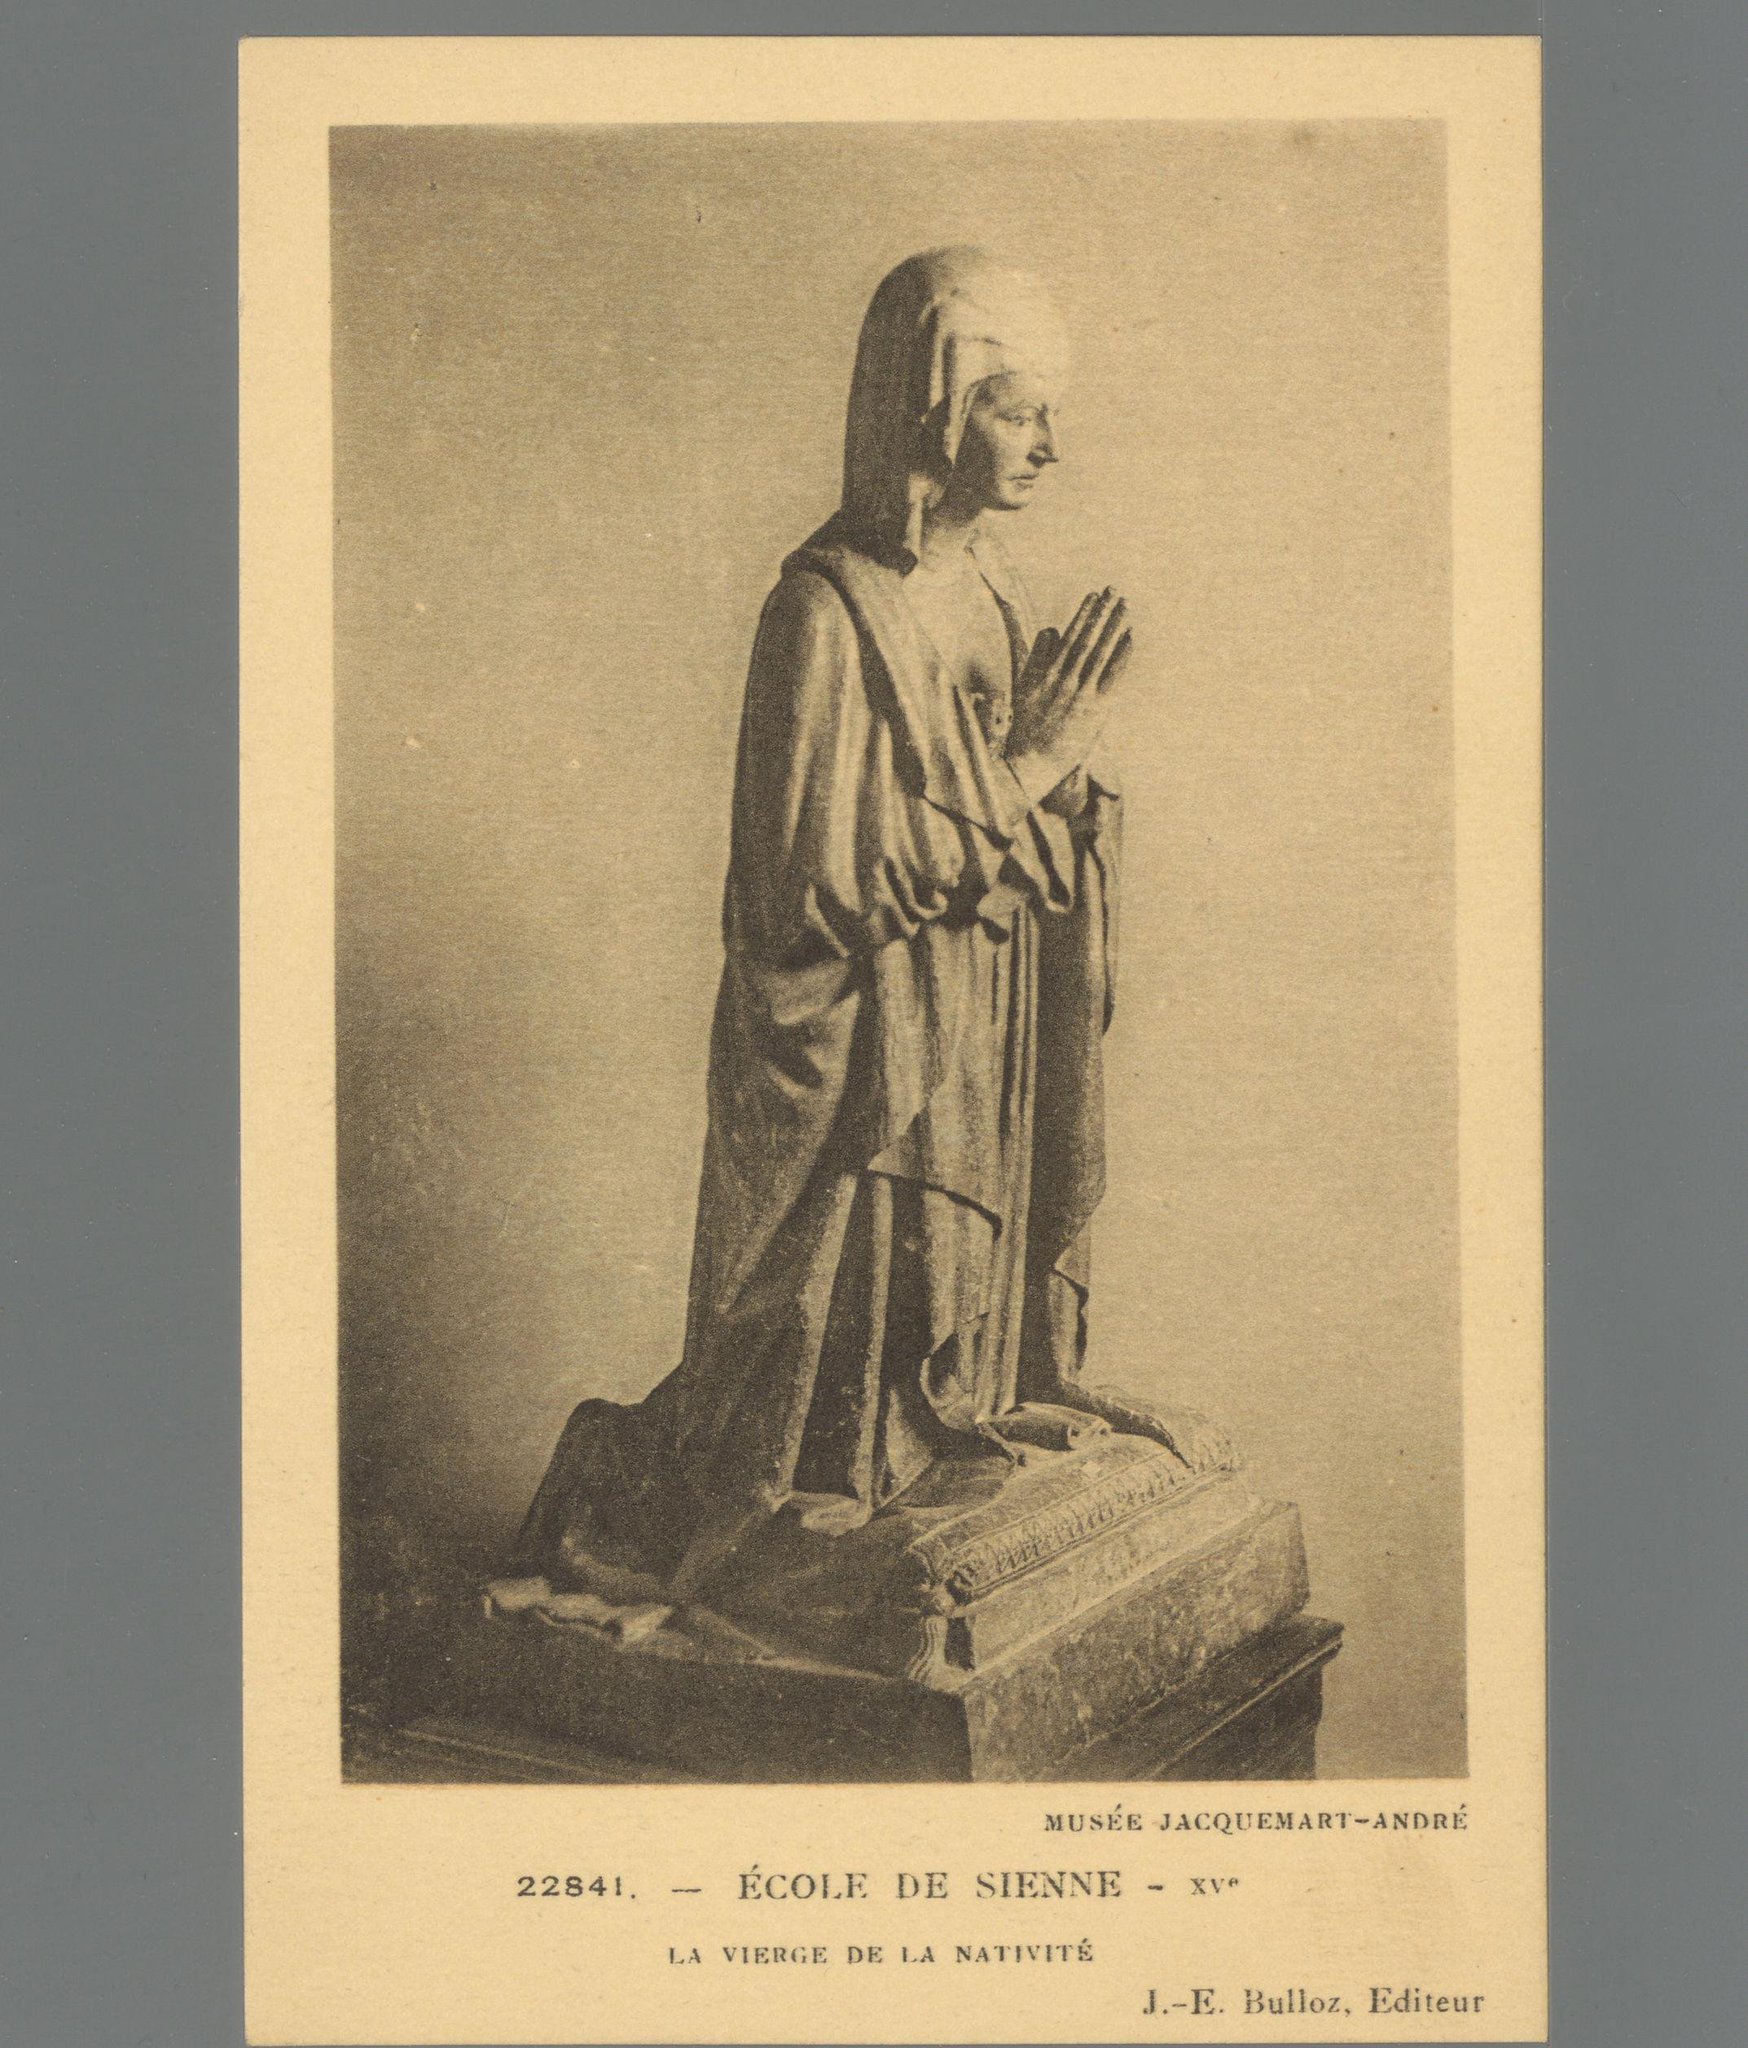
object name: ansichtkaart, prentbriefkaart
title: Musée Jacquemart-André. École de Sienne - XVe. La vierge de la nativité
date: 1903-1930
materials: cardboard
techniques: photograph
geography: paris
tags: statues, paintings, etc. ~ objects of worship in roman religion, permanent exhibition, museum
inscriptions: collector's mark: ‘AFE v S’